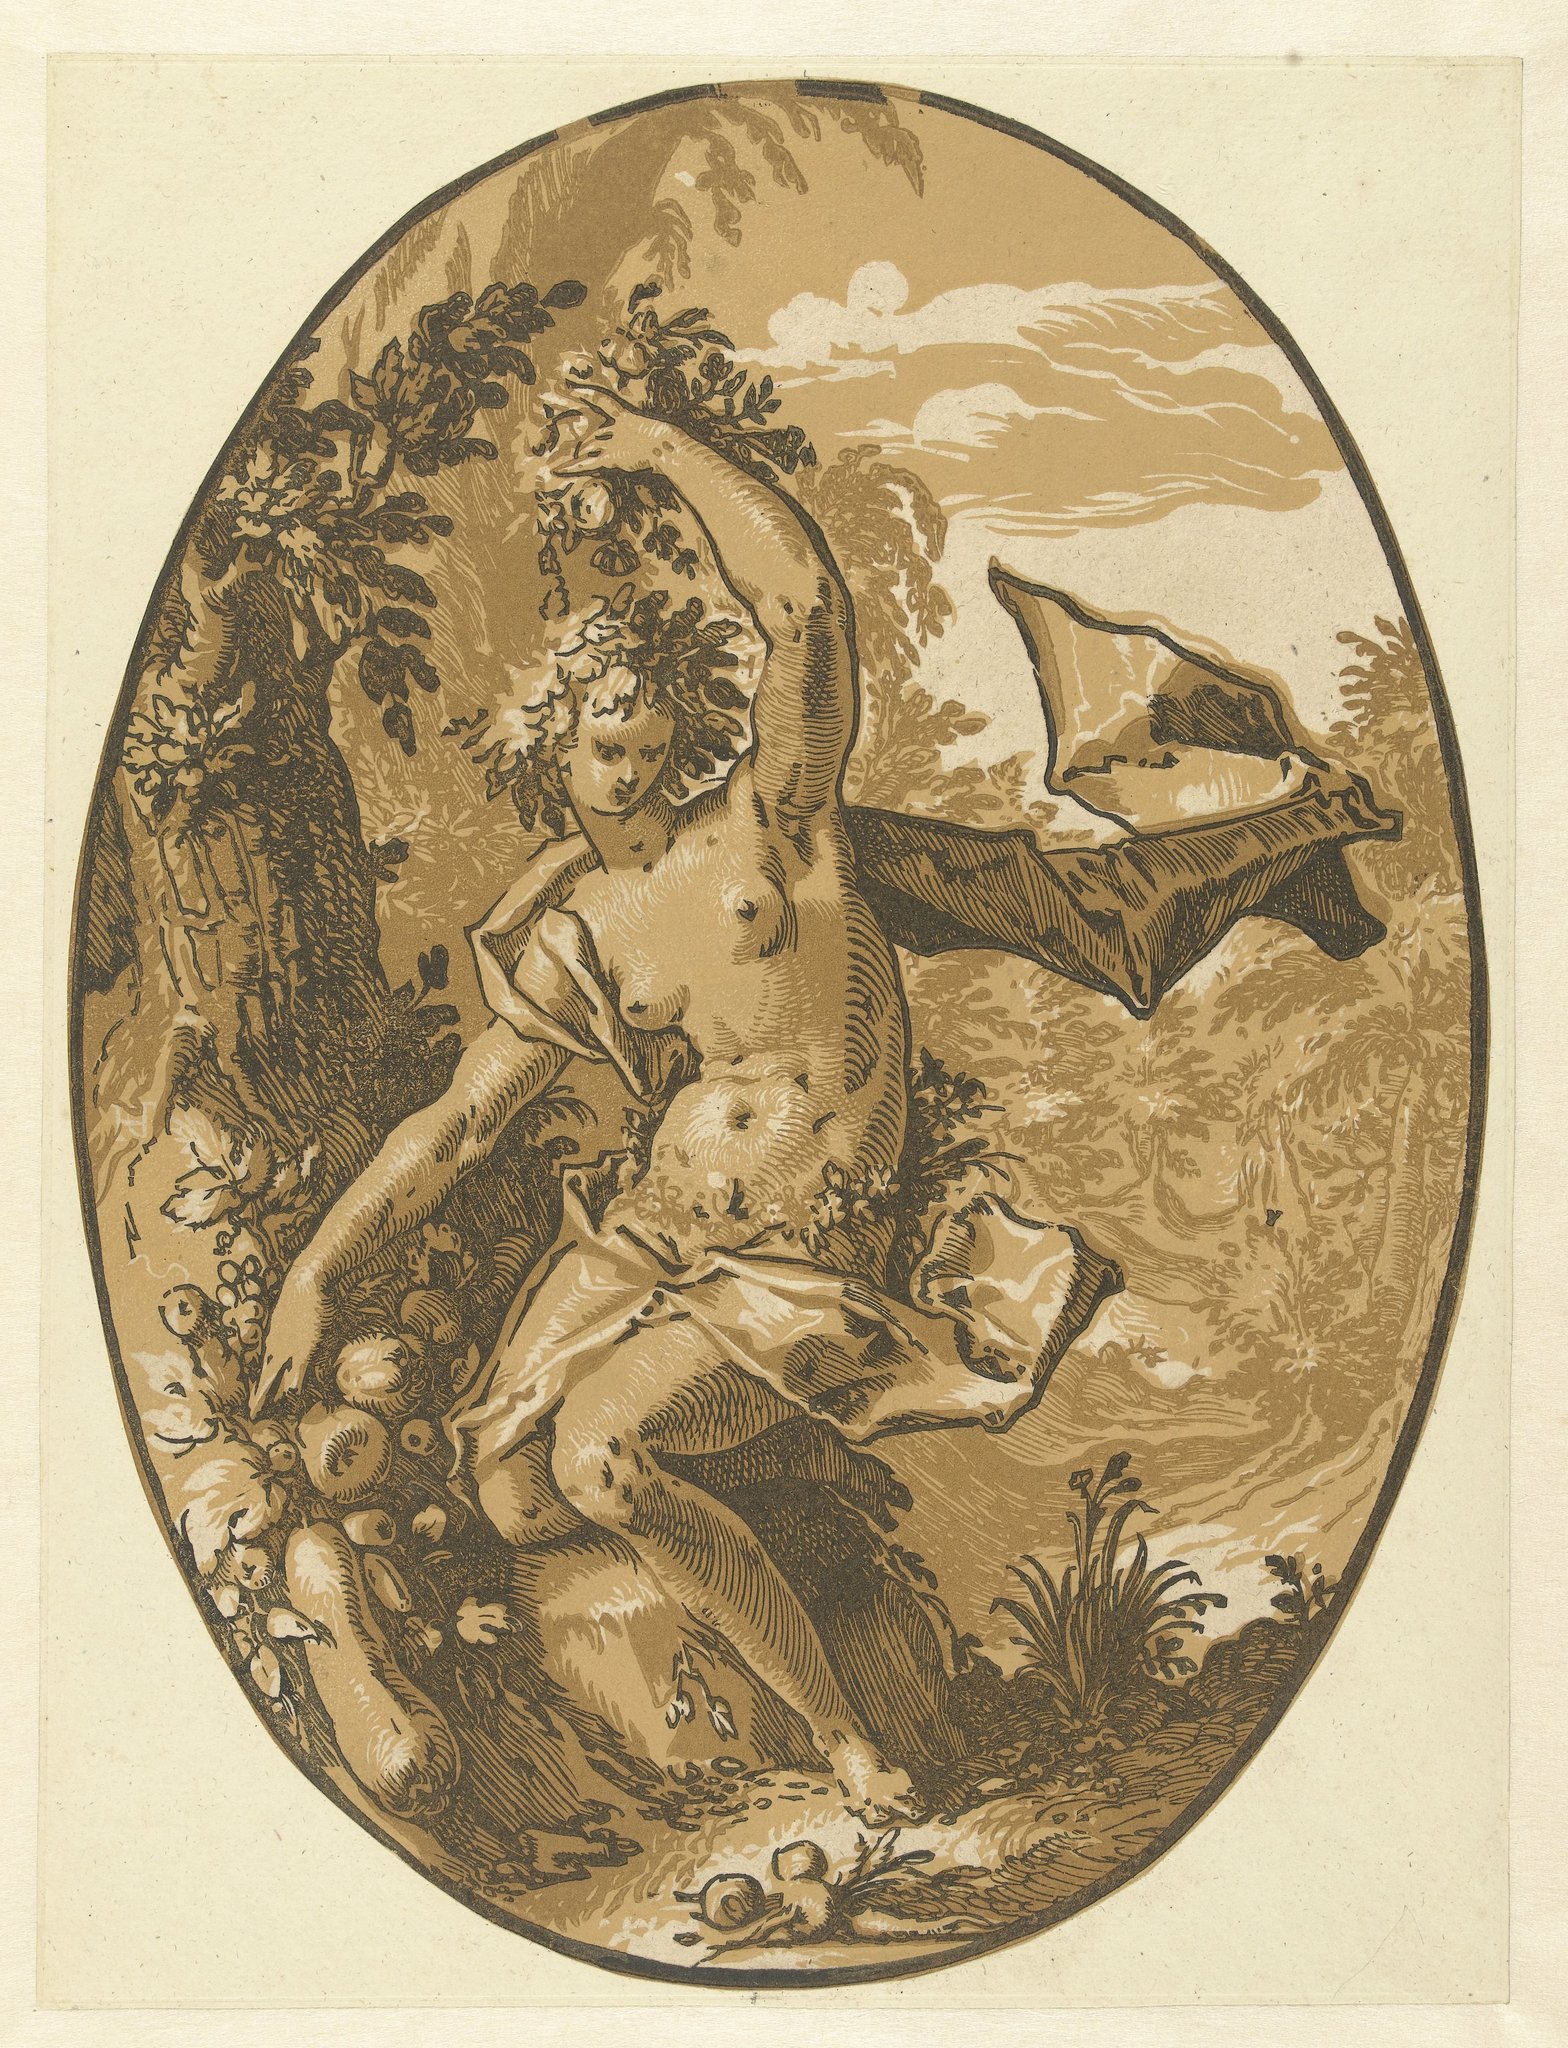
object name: print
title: Goden en godinnen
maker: hendrick goltzius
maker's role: draughtsman, painter, print maker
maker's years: 1558-1617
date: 1588-1590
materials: paper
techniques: woodcut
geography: haarlem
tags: (story of) proserpina (persephone, core), libera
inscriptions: collector's mark: Lugt 240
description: De godin Proserpina, gezeten bij een boom, fruit en bloemen in de handen. Deze prent is onderdeel van een serie van zeven ovale prenten van klassieke goden en godinnen.